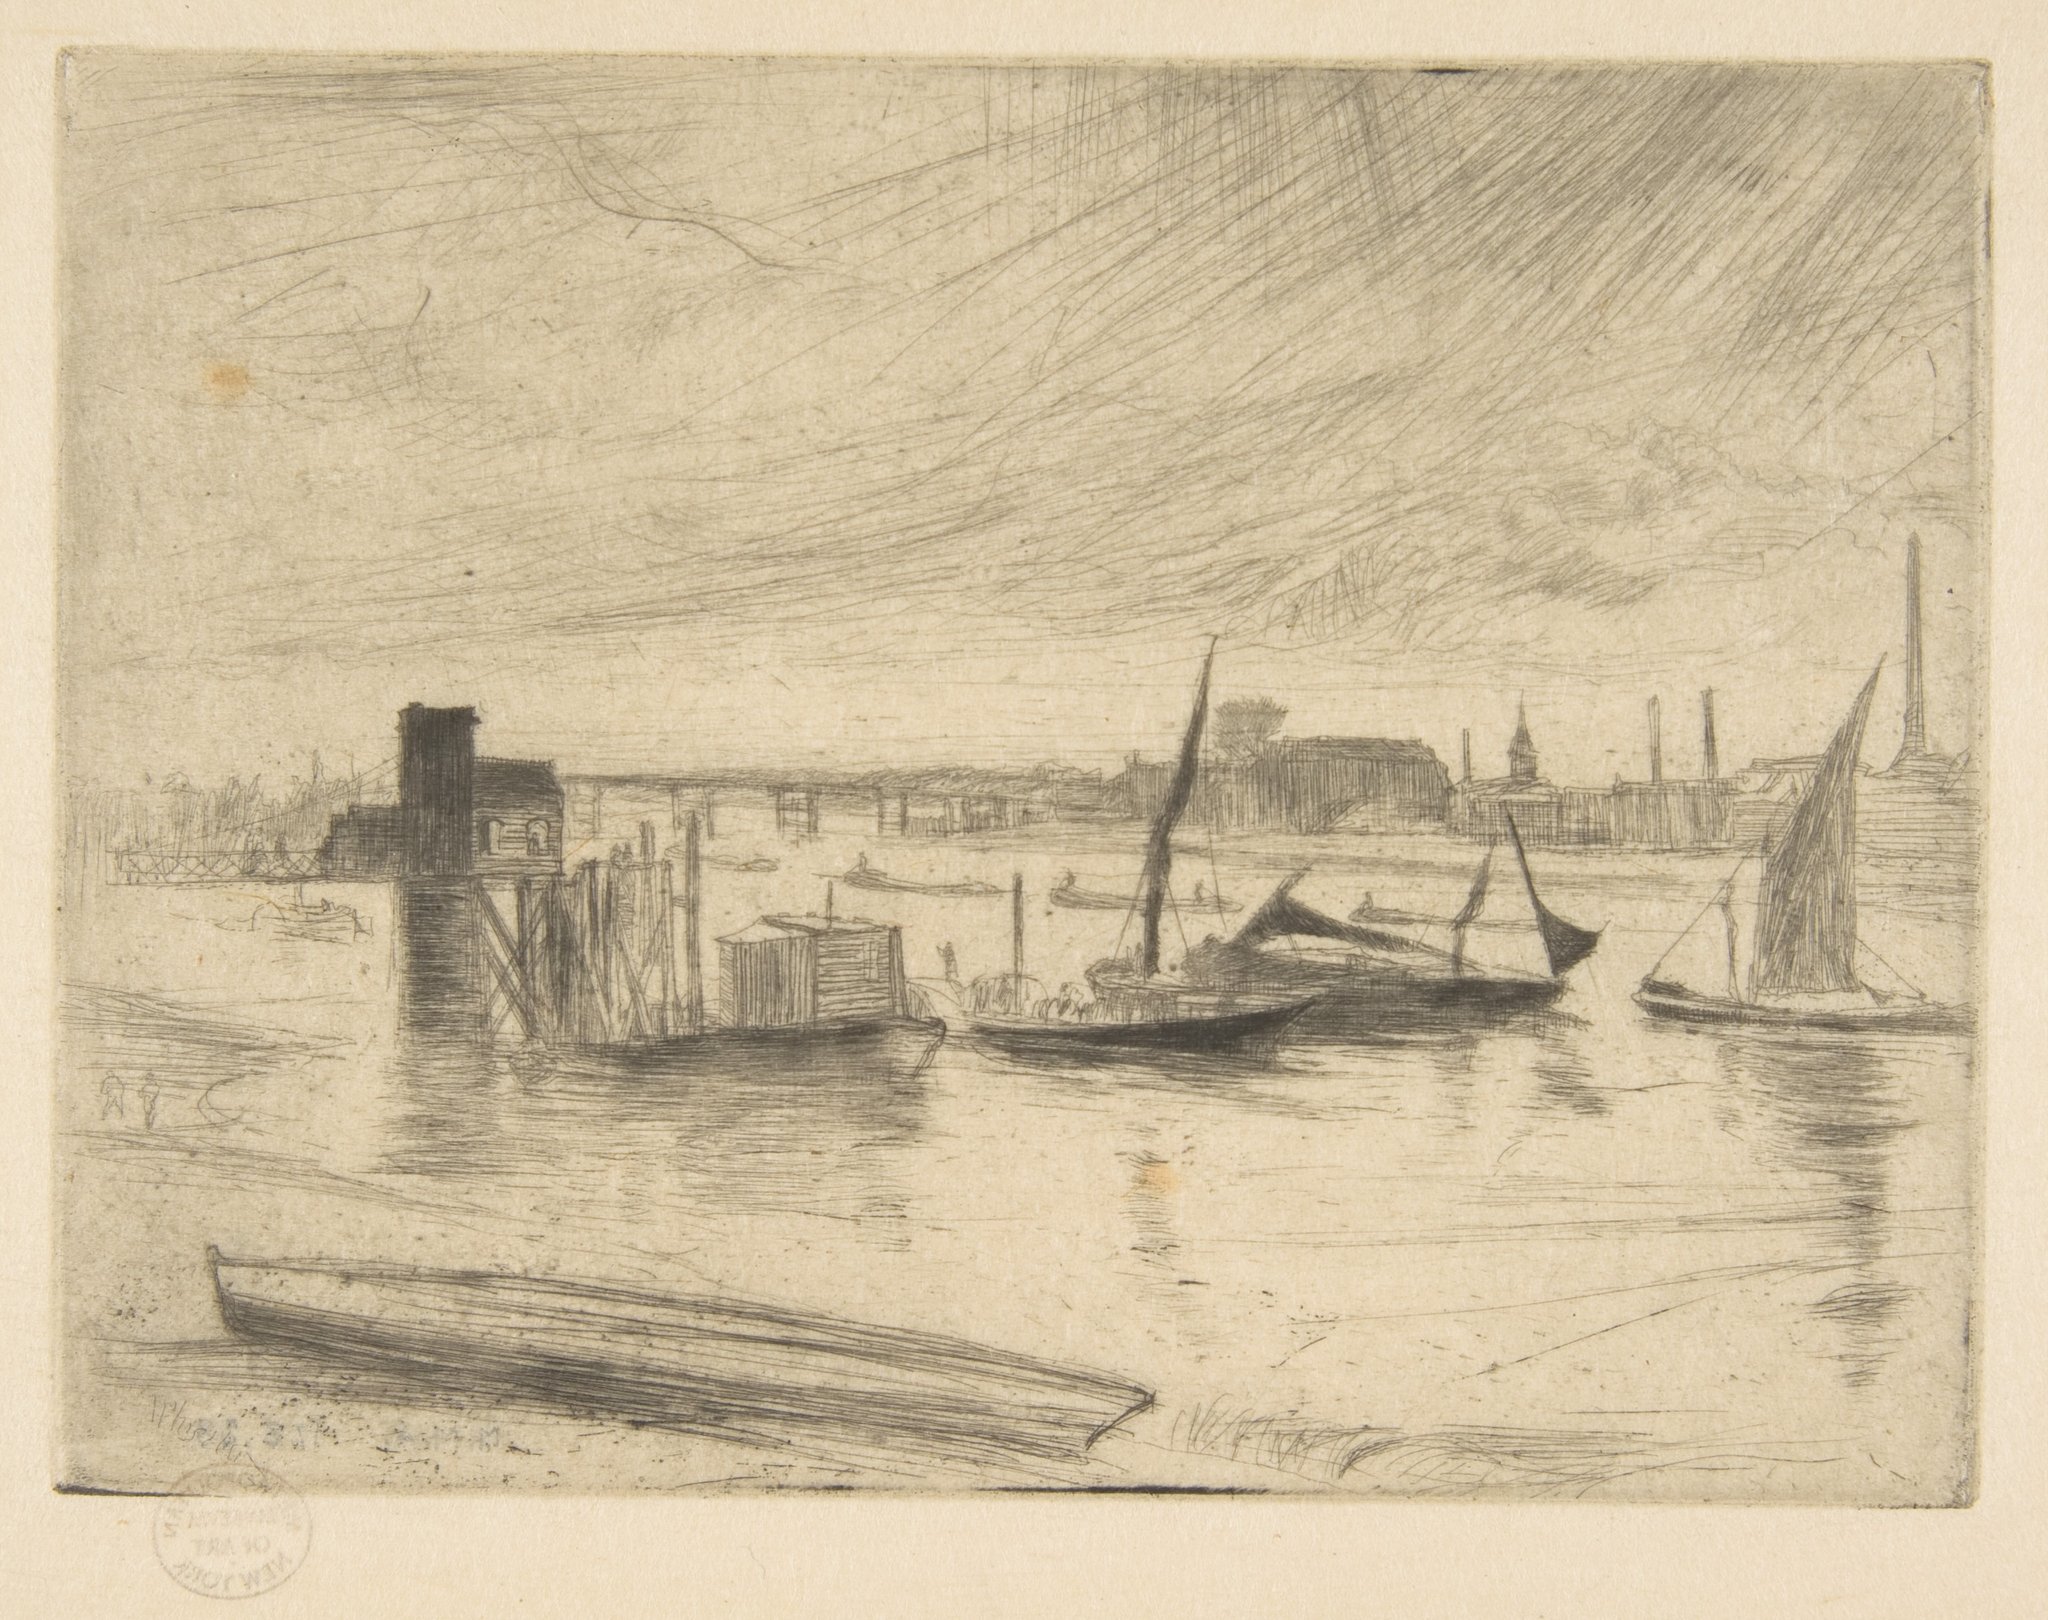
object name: print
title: Early Morning, Battersea (Battersea Dawn) (Cadogan Pier)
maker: james mcneill whistler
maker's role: artist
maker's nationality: american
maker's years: 1834-1903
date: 1863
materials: ink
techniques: drypoint, etching, printing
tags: dawn,boats